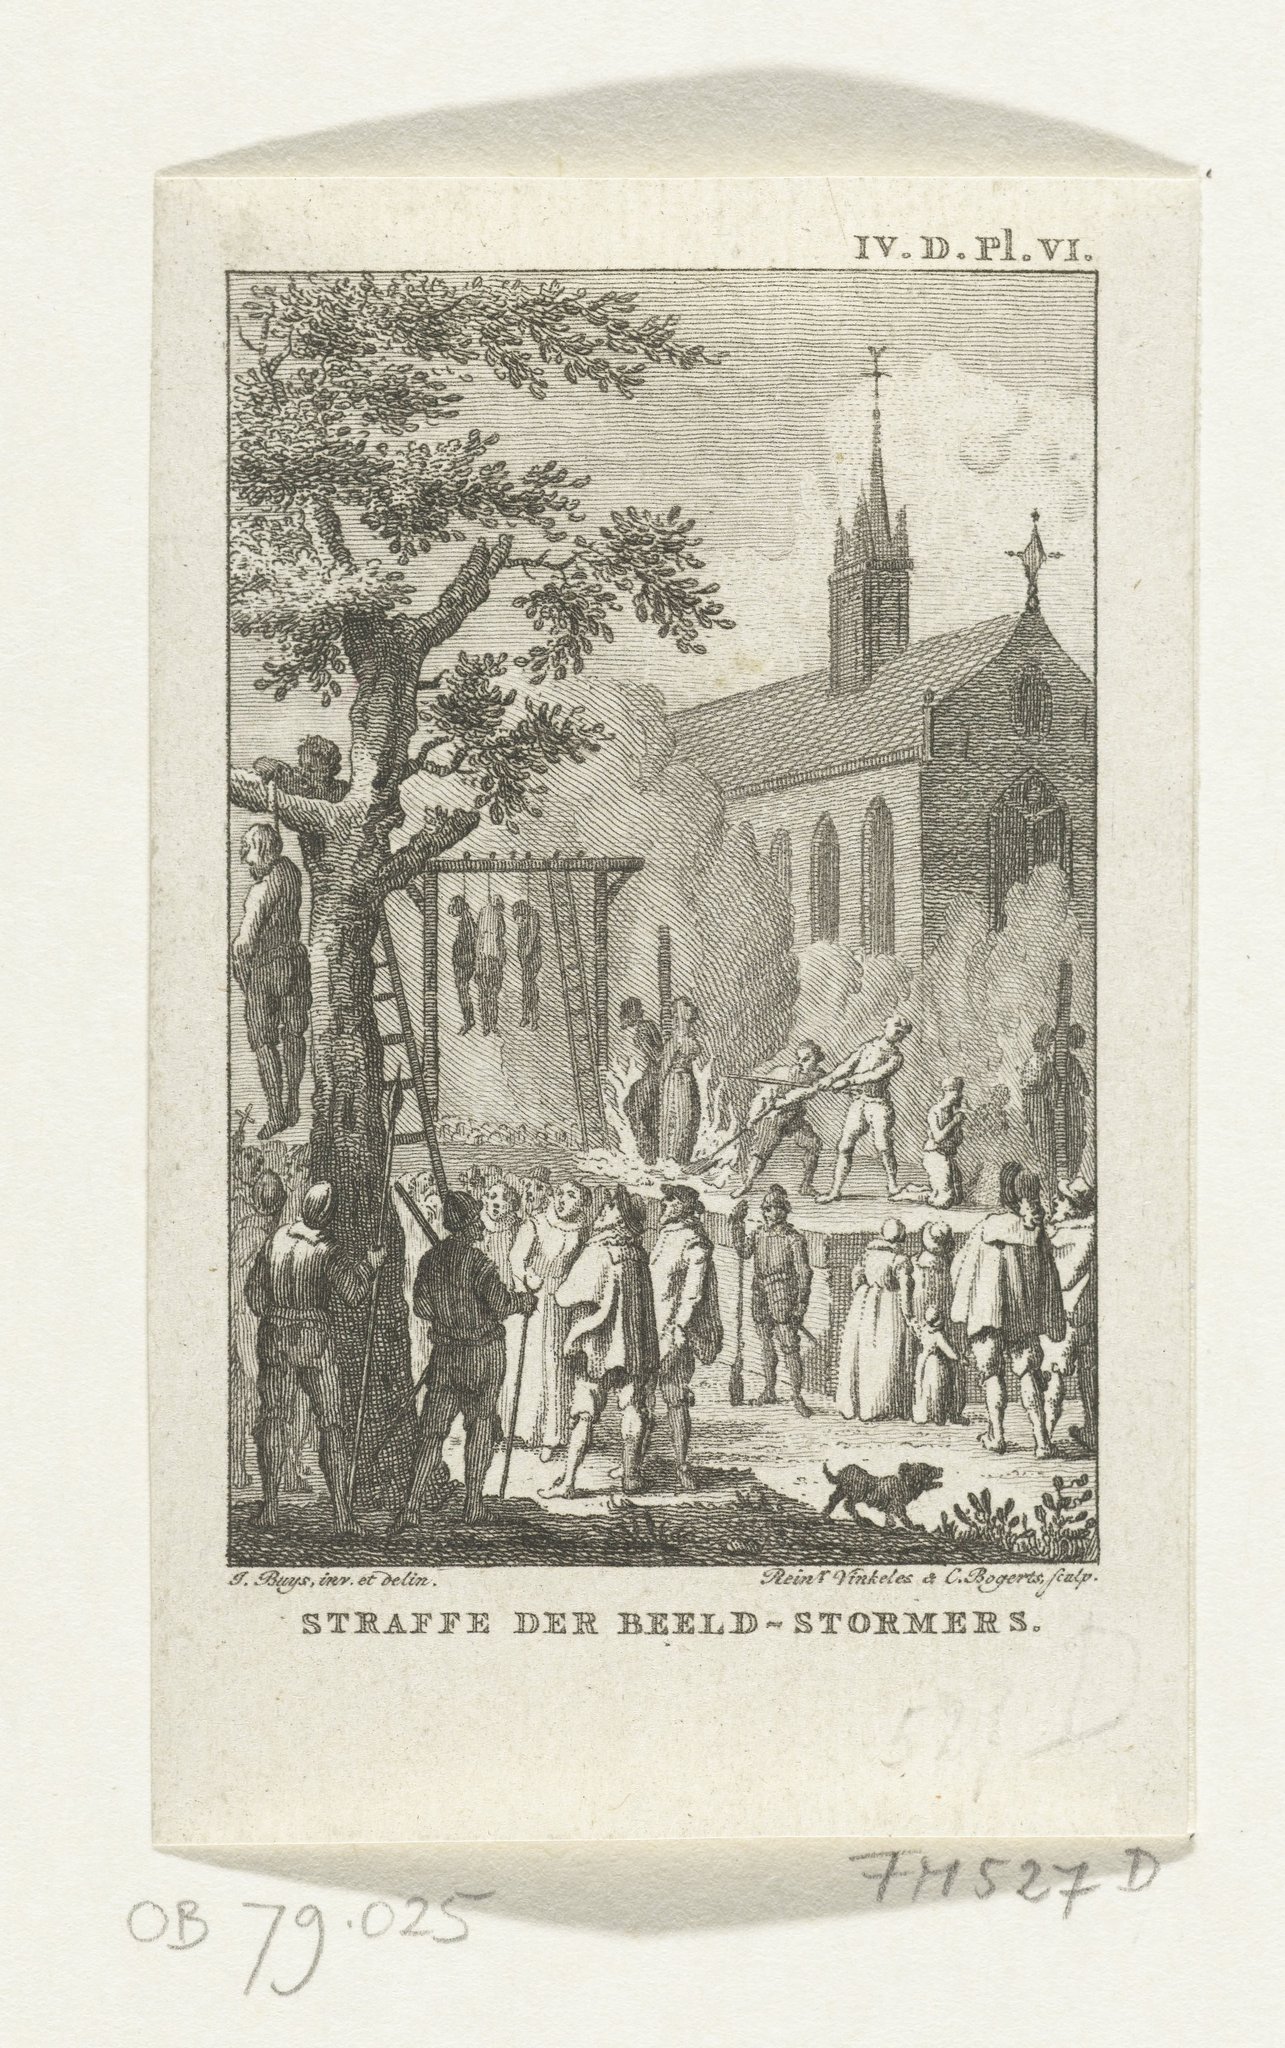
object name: history print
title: Straffe der Beeld-stormers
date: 1780-1795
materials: paper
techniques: etching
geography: netherlands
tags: execution of heretic, e.g. by burning at the stake, 'auto-da-fé', on the scaffold or place of execution, violent death, being killed; being mishandled and maltreated; seeking death, beeldenstorm (1566)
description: Illustratie voor: J. Fokke, Geschiedenissen der Vereenigde Nederlanden voor de vaderlandsche jeugd, Johannes Allart, Amsterdam 1783-1795, 25 delen, dl. IV, pl. VI. Niet in Frederik Muller; door het RPK toegevoegd nummer.